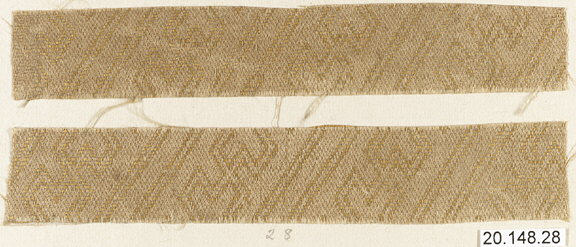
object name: brocade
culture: china or japan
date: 1501-1600